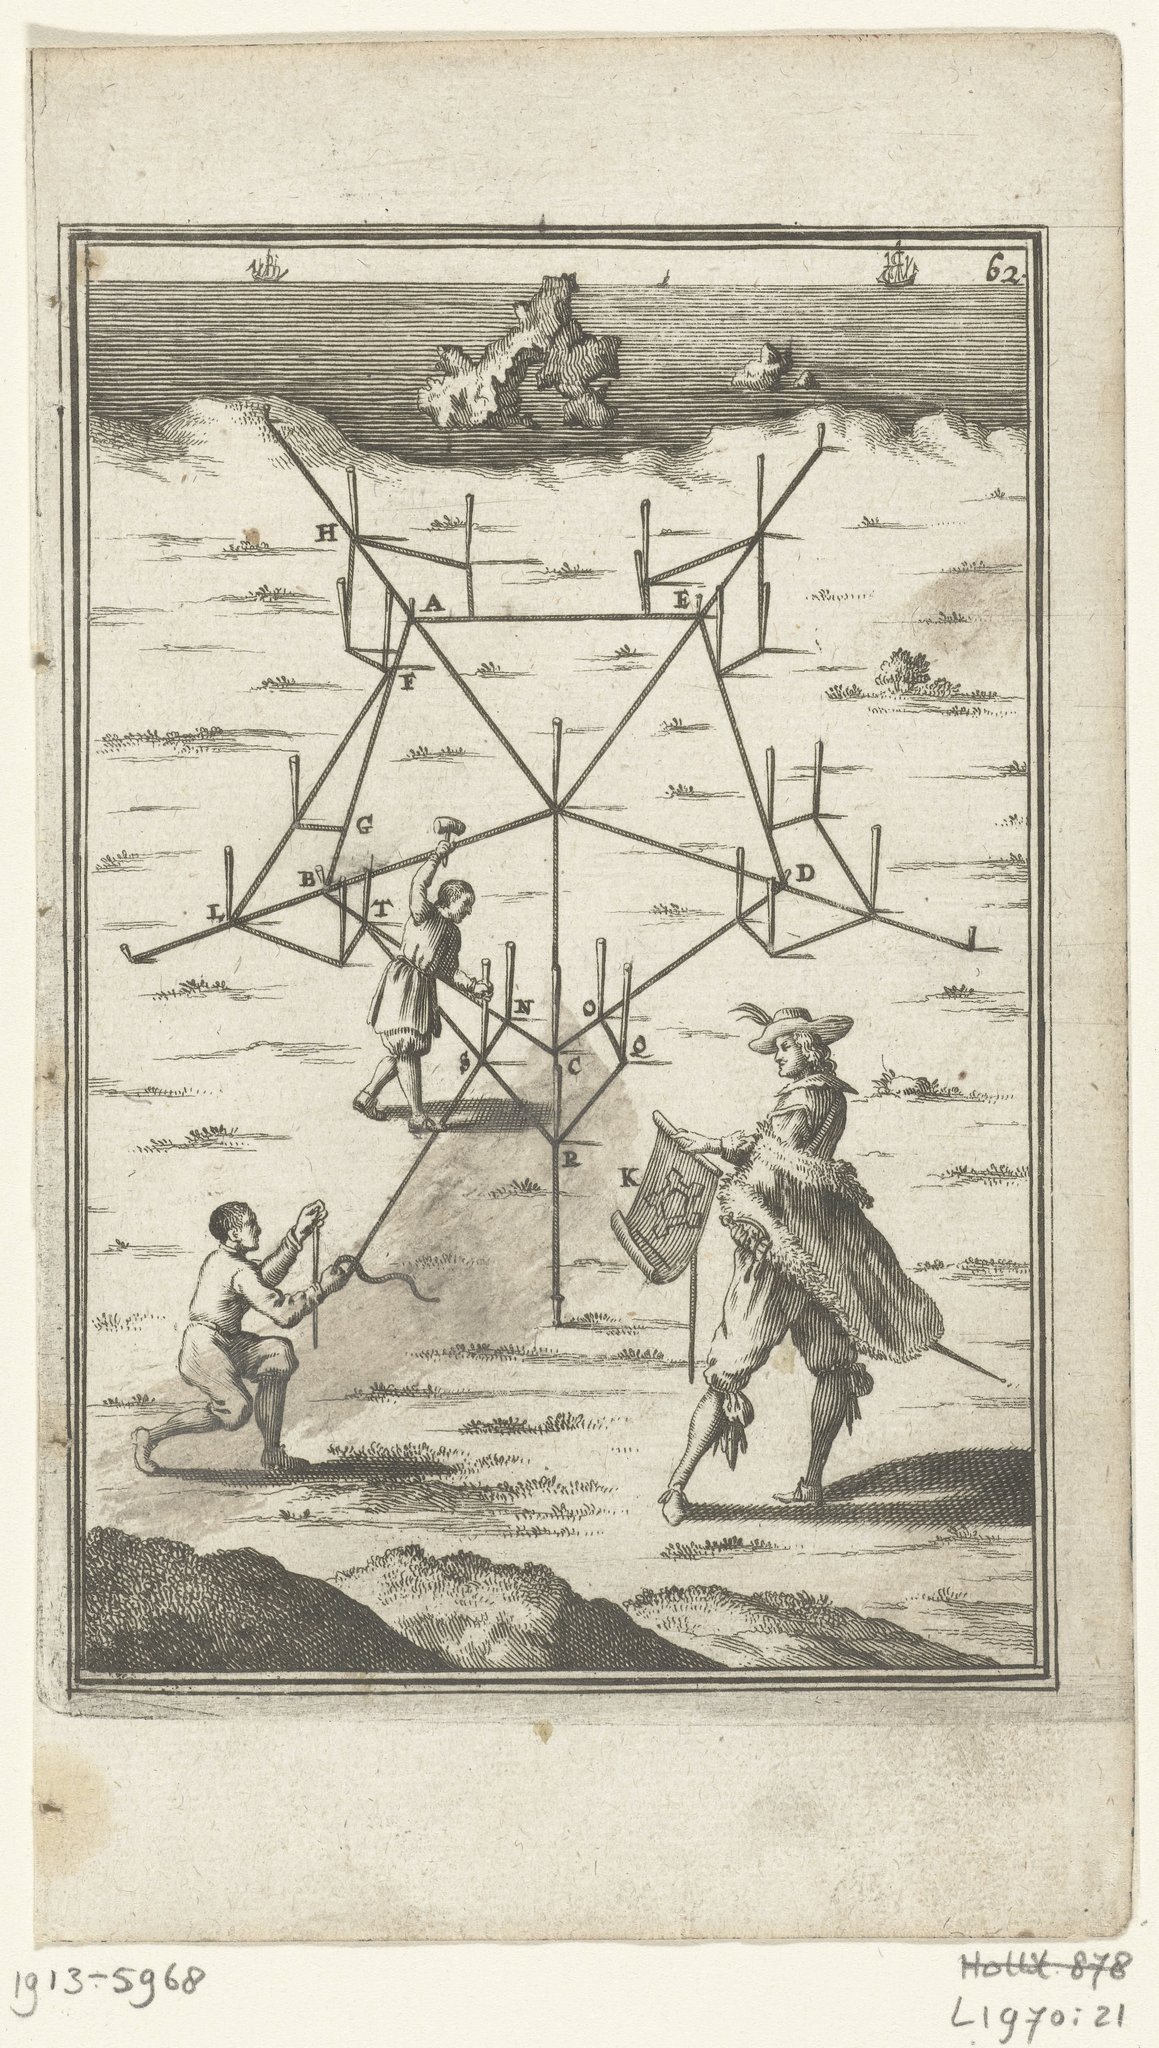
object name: print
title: Illustratie voor 'Den Arbeid van Mars' van Allain Manesson Mallet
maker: romeyn de hooghe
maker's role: draughtsman, goldsmith, painter, print maker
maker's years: 1645-1708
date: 1672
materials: paper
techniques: engraving, etching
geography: amsterdam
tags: landscape with other man-made constructions not mentioned above, e.g.: graveyards, playgrounds, etc., sea (seascape), fortifications, military engineering, coast, mathematics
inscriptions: collector's mark: Lugt 2228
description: Twee mannen die onder leiding van een derde in een kustlandschap bezig zijn met het uitzetten van de omtrekken van een vesting, fort of versterking (vijfhoek). In de hoek rechtsboven het cijfer 62 (= het nummer van de pagina in het boek waartegenover de illustratie geplaatst is).